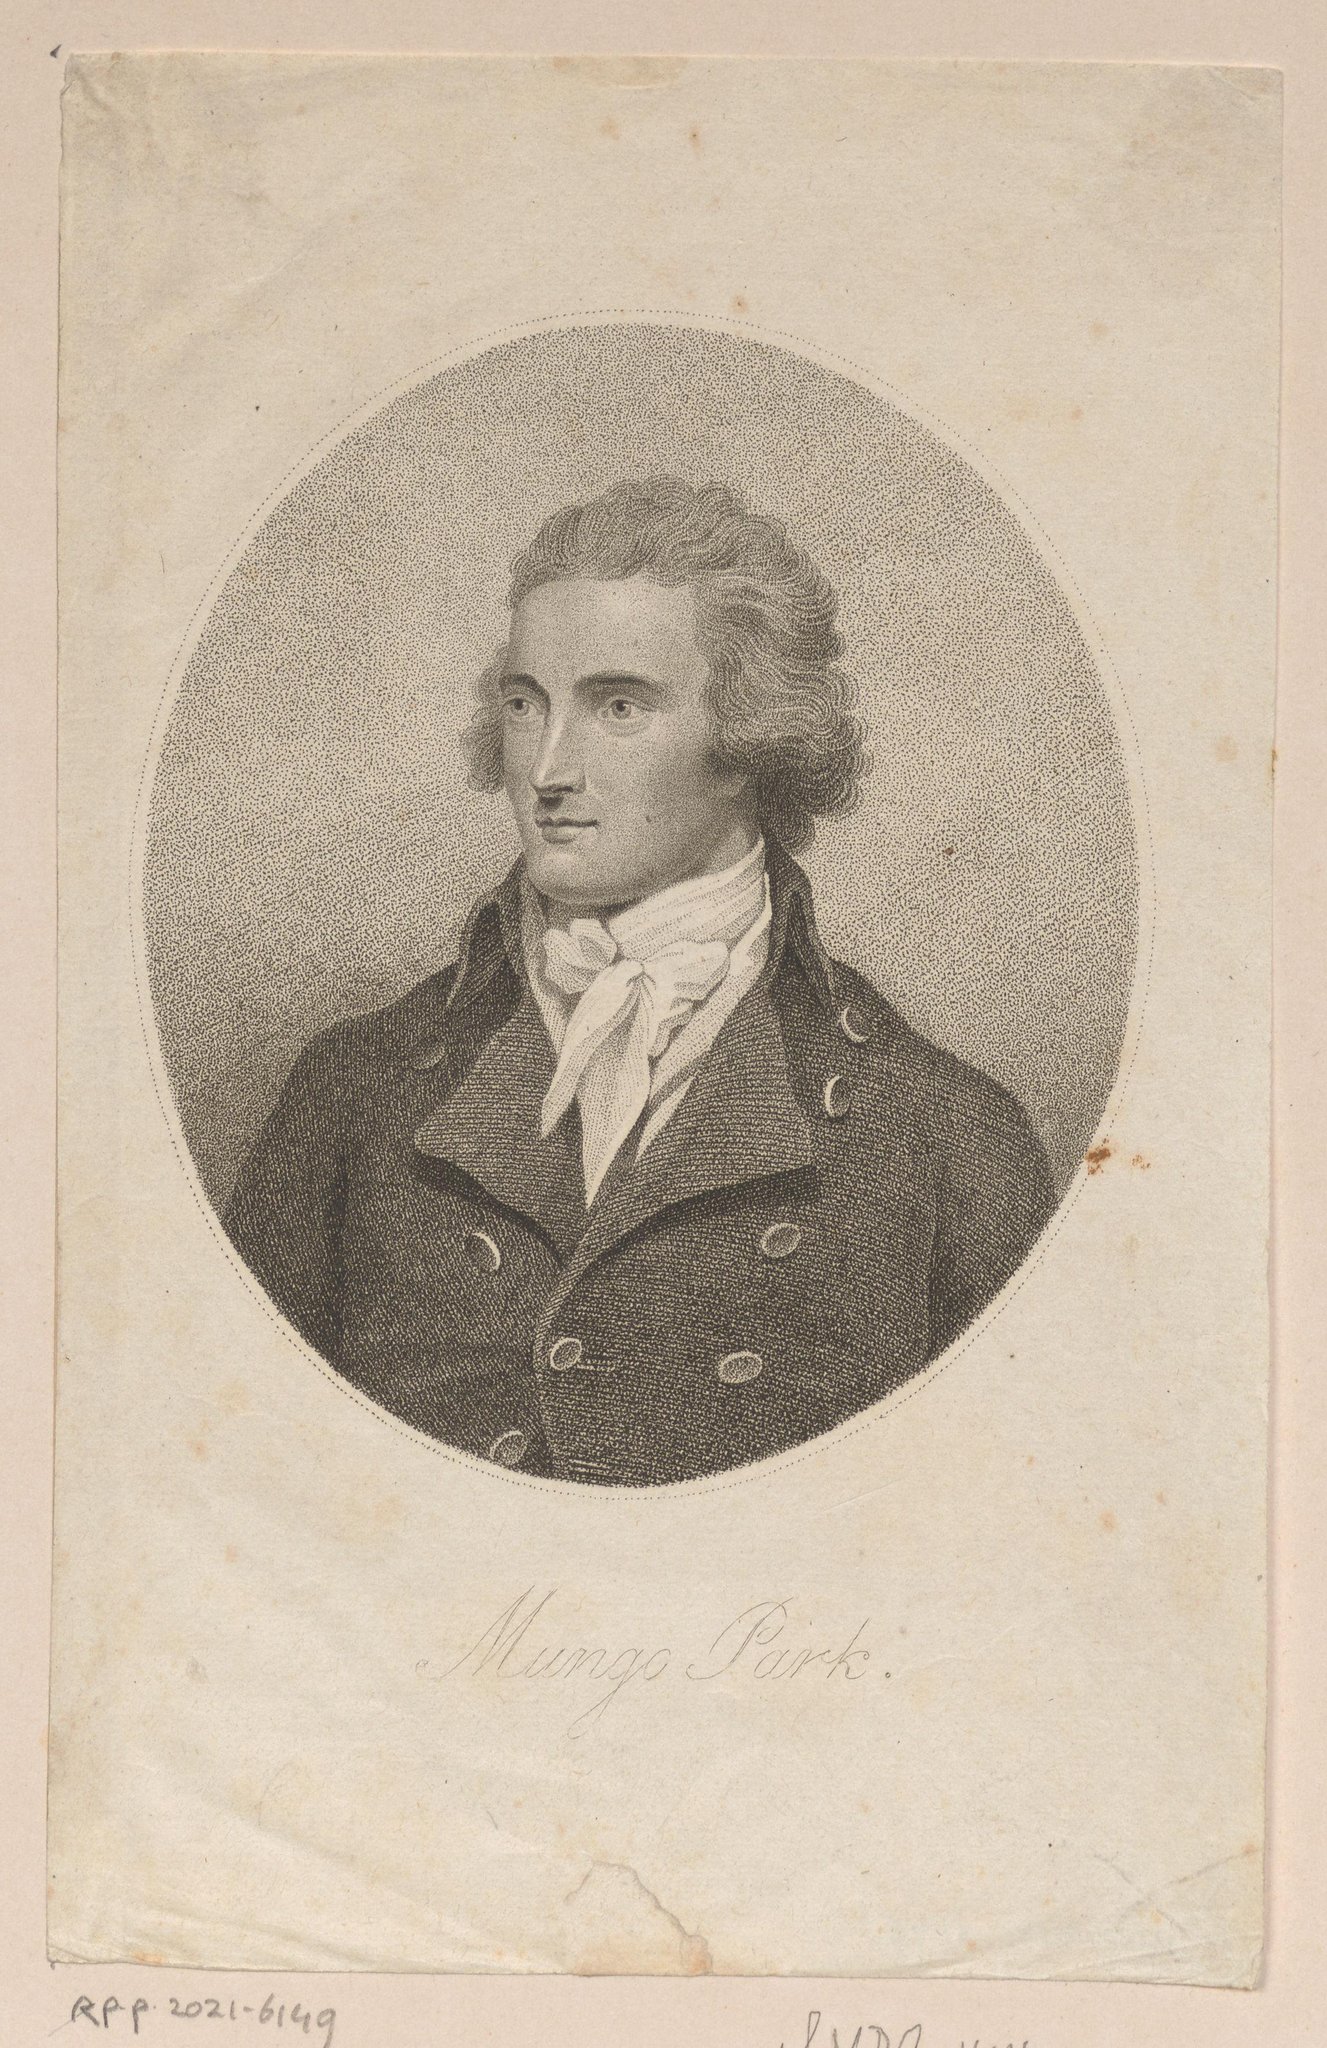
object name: print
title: Portret van Mungo Park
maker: Anonymous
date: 1792-1820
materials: paper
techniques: engraving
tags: adult man, historical persons, explorer